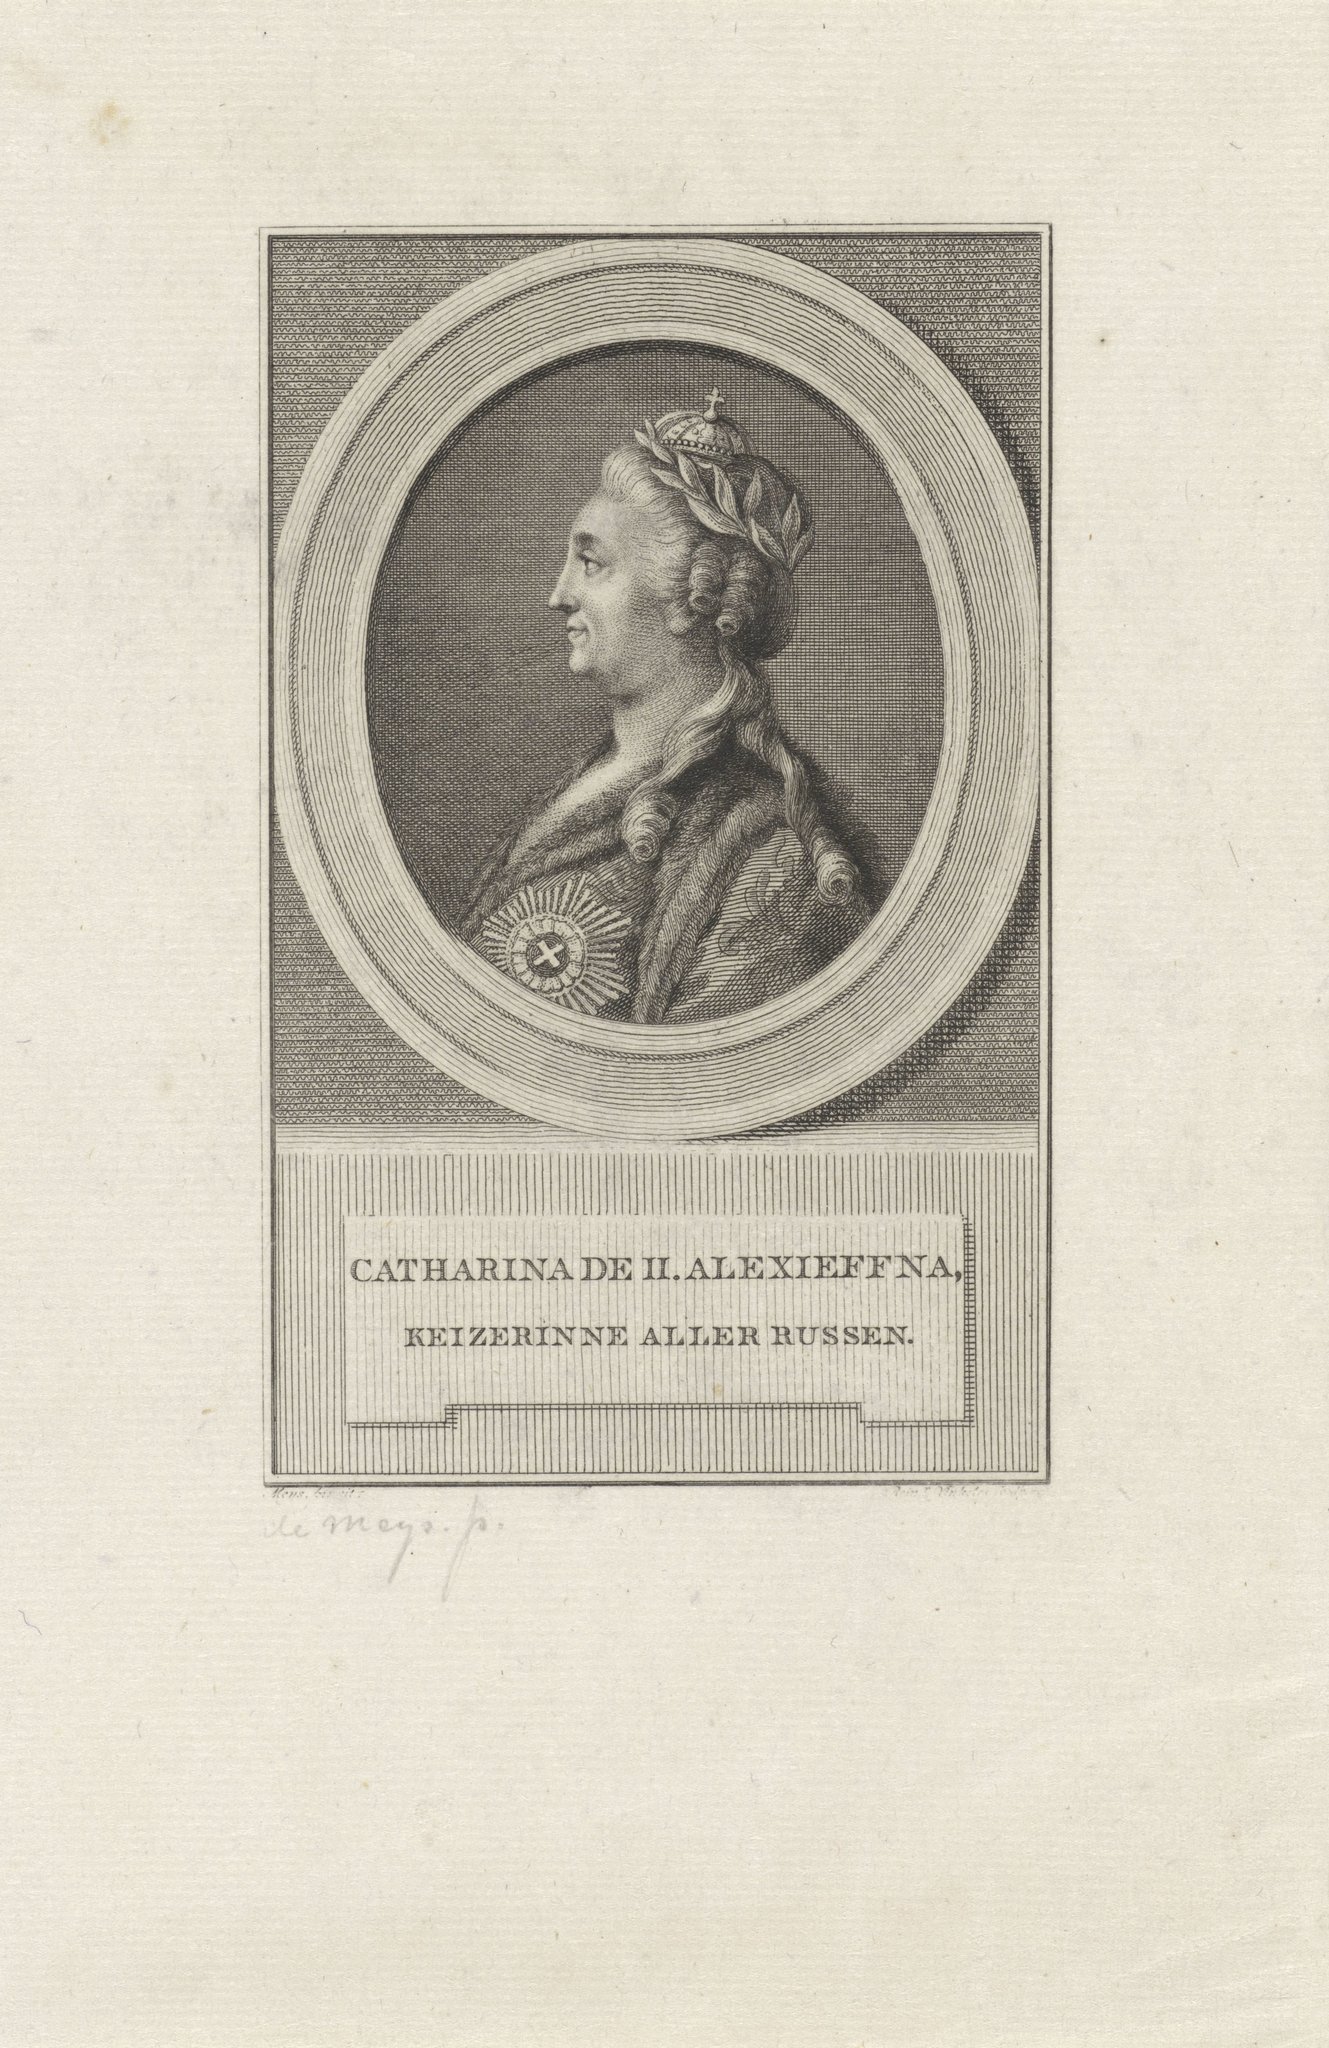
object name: print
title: Portret van Catharina de Grote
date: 1790-1816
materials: paper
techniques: engraving, etching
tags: catharina de grote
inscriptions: collector's mark: Lugt 240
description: Portret van Catharina de Grote, tsarina van Rusland.